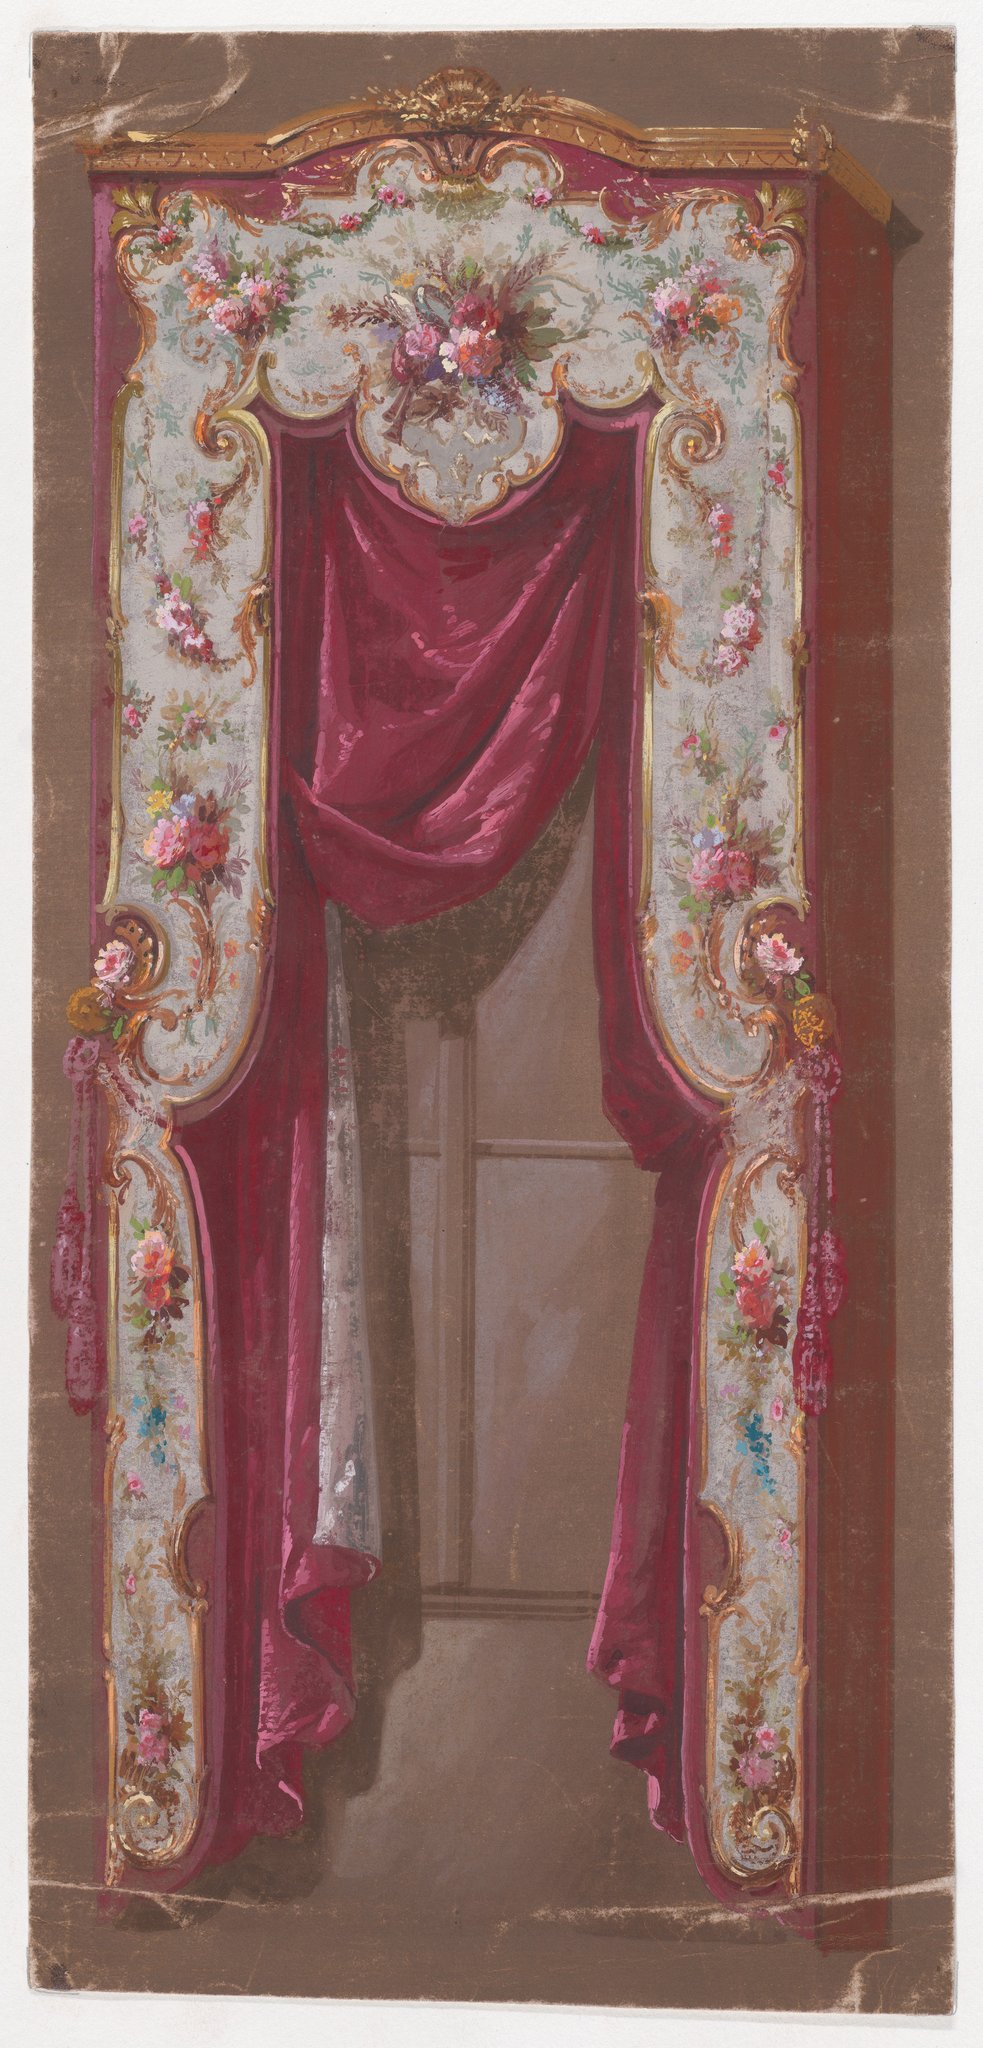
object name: drawing ornament architecture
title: Design for a Valance in with Thin Bushes and Garlands of Flowers and a Shell Motif with a Hanging Curtain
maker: anonymous, french, 19th century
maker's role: designer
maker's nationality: french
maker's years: 1800-1900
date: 1870-1900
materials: watercolor